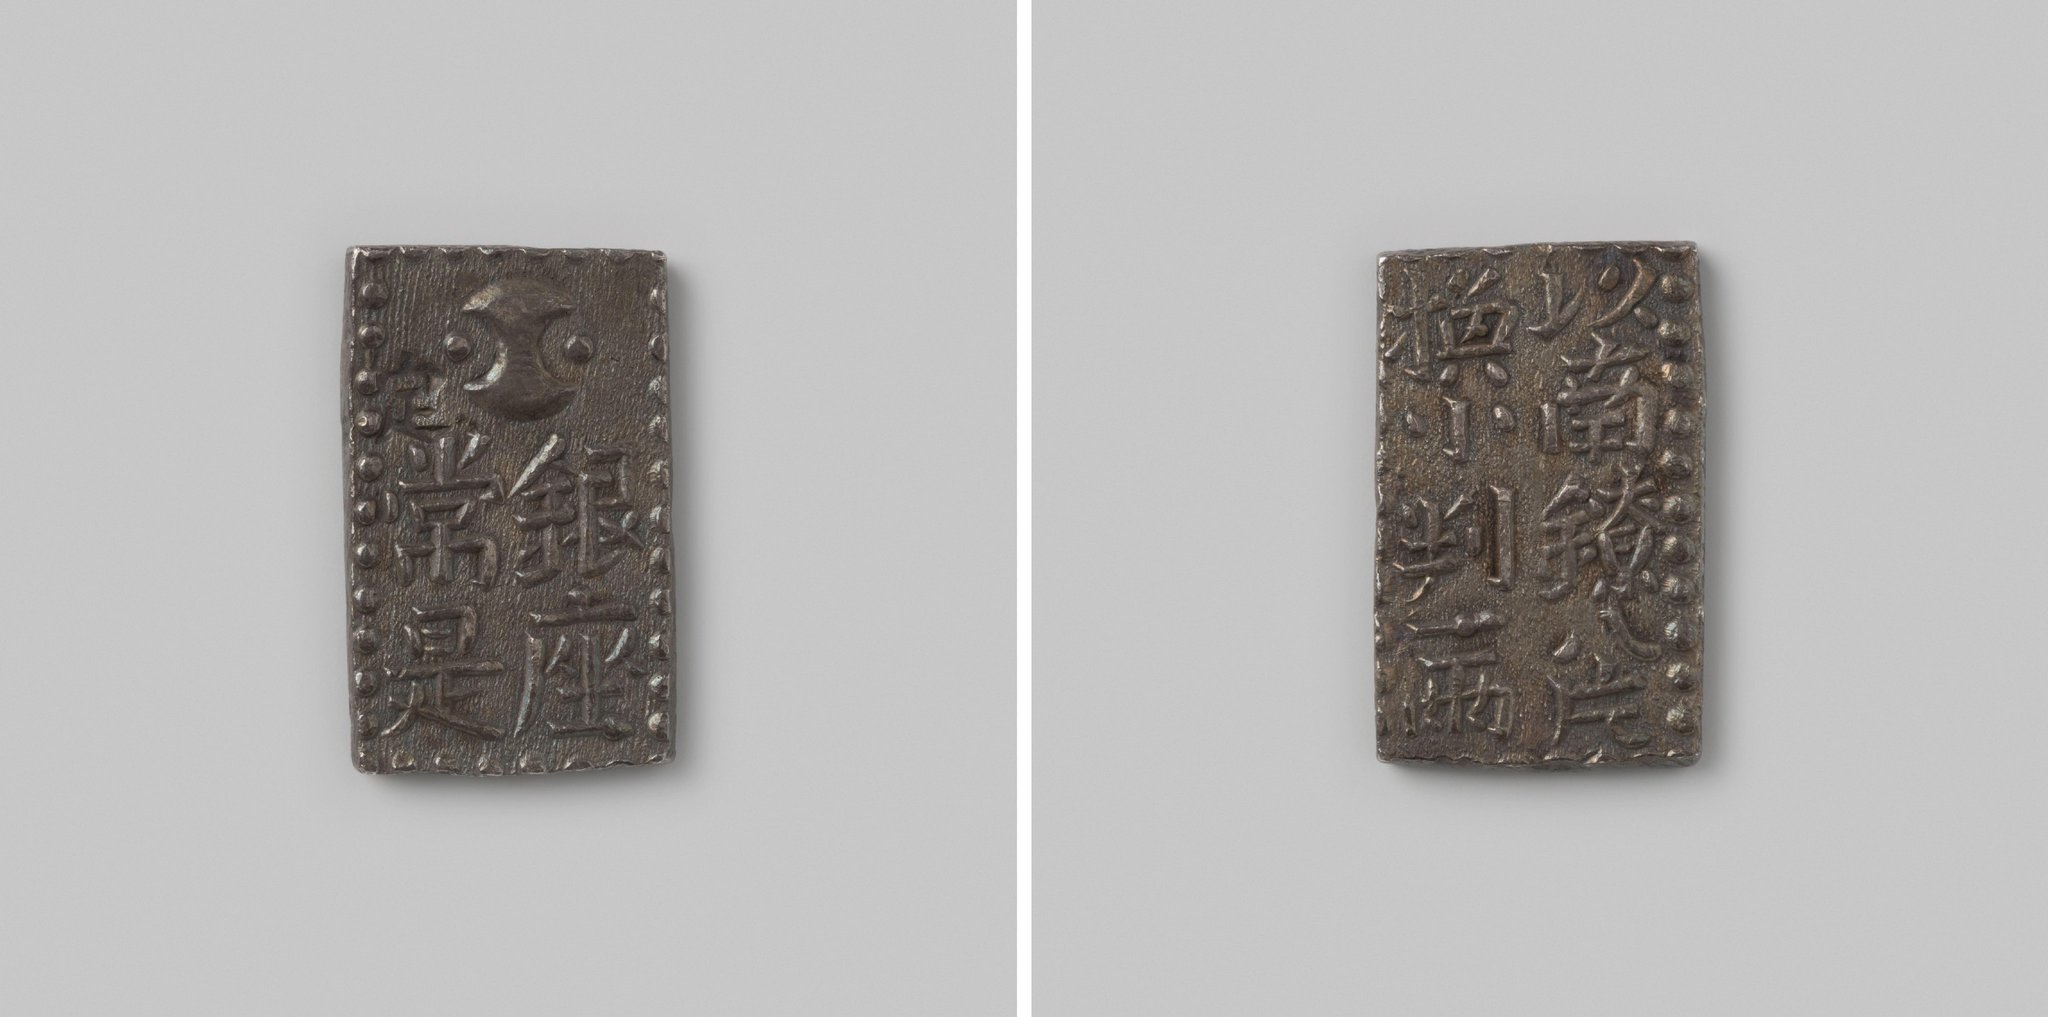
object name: coin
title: Nan rio gin uit het keizerrijk Japan van keizer Nin-kau uit het Bunsei tijdperk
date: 1824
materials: silver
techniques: striking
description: Zilveren rechthoekige munt. Voorzijde: binnen rechthoek vier onder en naast elkaar geplaatste tekens. Daarboven versiering. Keerzijde: binnen rechthoek acht onder en naast elkaar geplaatste tekens, waaronder waarde-aanduiding.